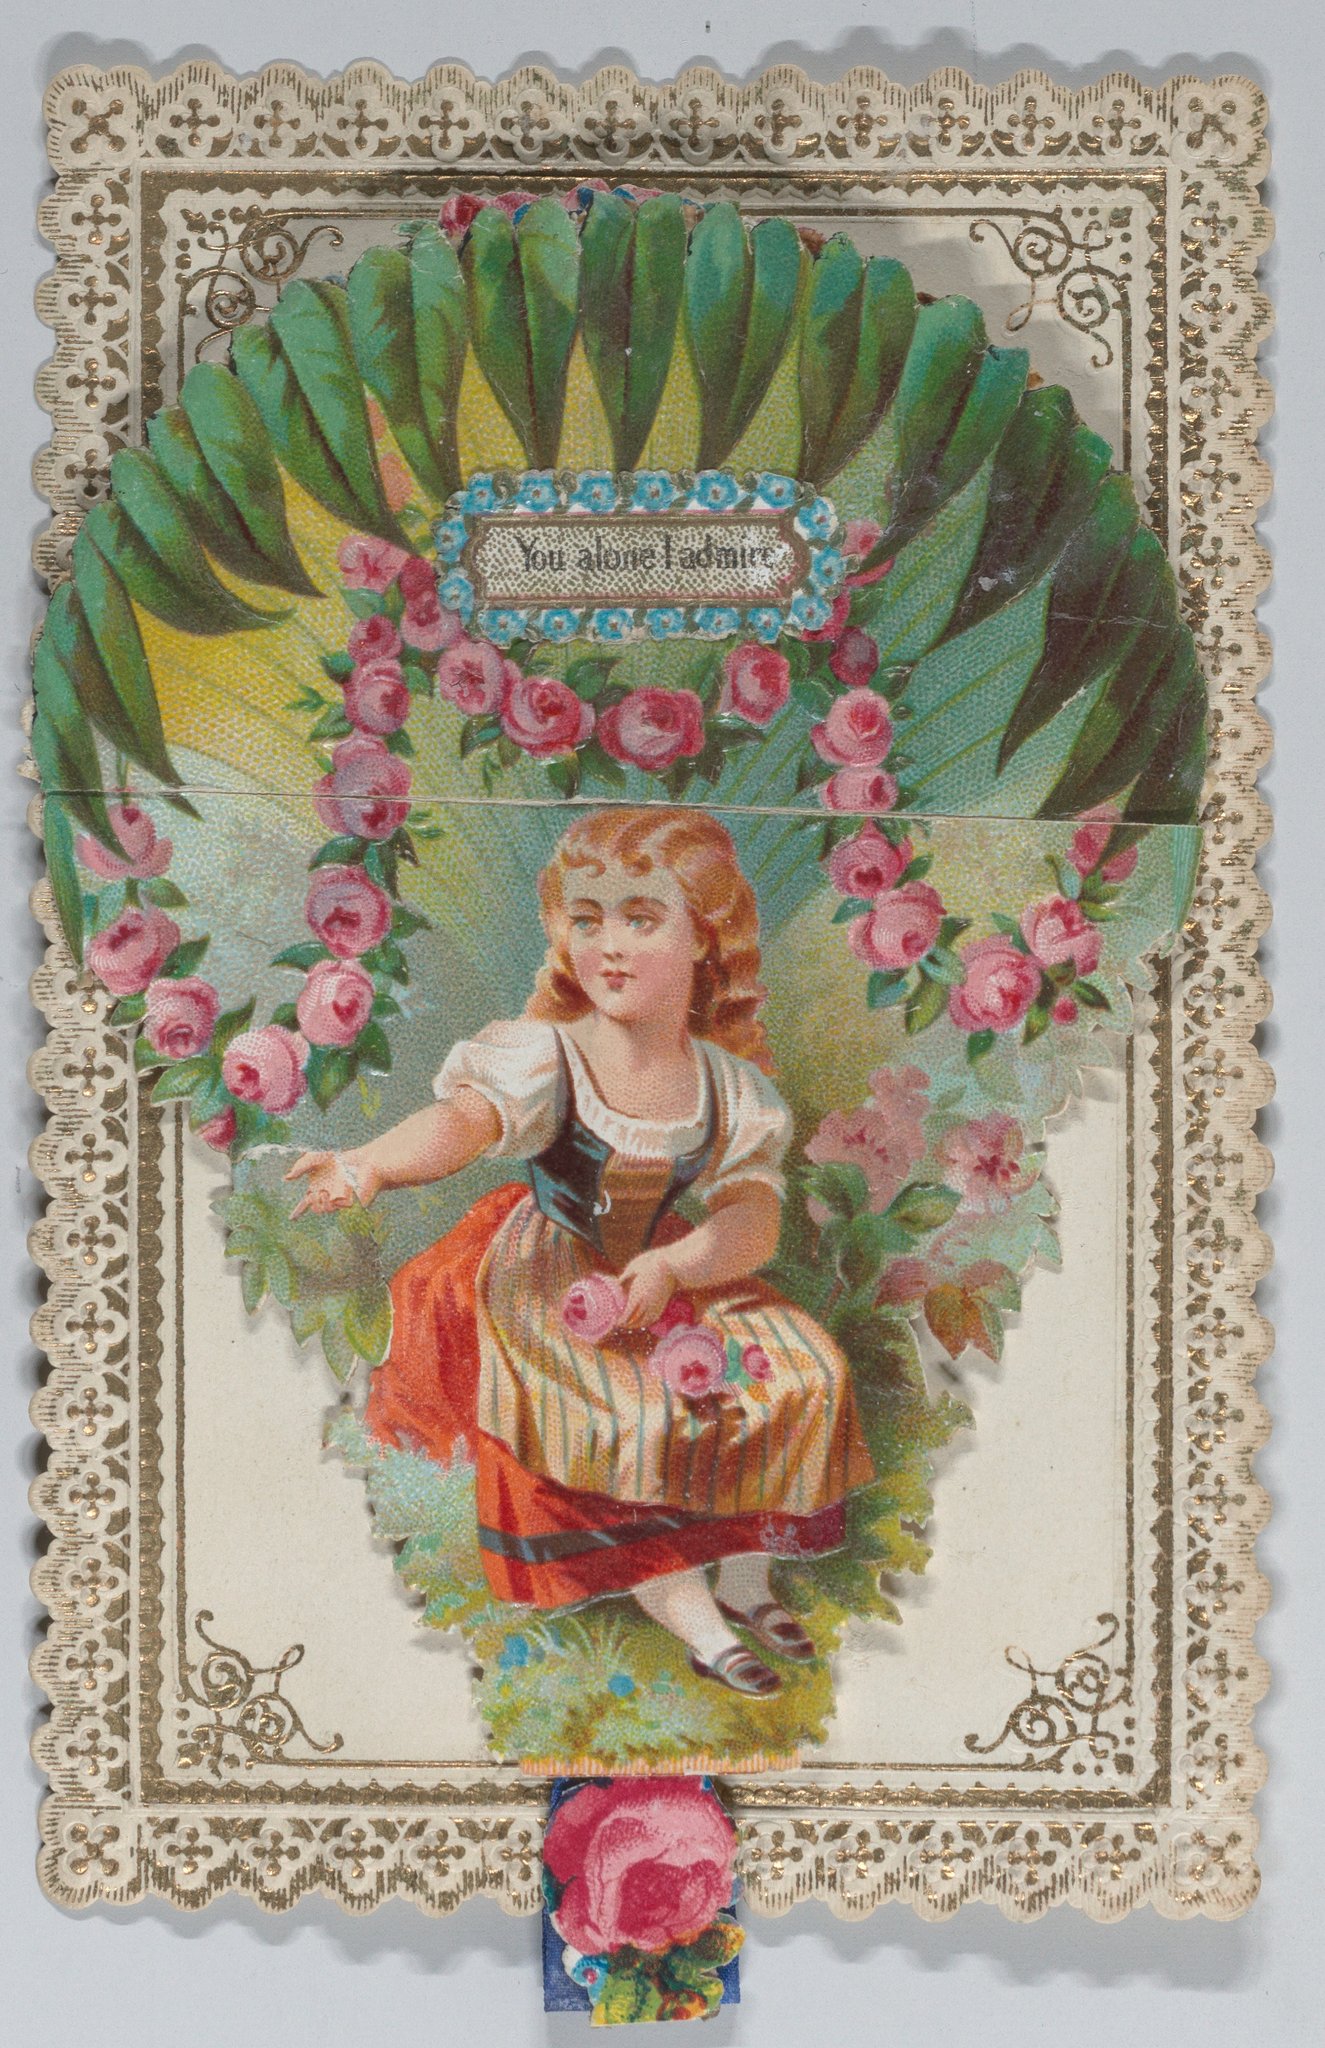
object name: valentine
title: Valentine - Mechanical, layers of roses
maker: anonymous, british, 19th century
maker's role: artist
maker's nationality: british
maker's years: 1800-1900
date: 1875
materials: lace, paper, ribbon, silk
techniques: chromolithography, cutting, gilding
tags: girls,roses